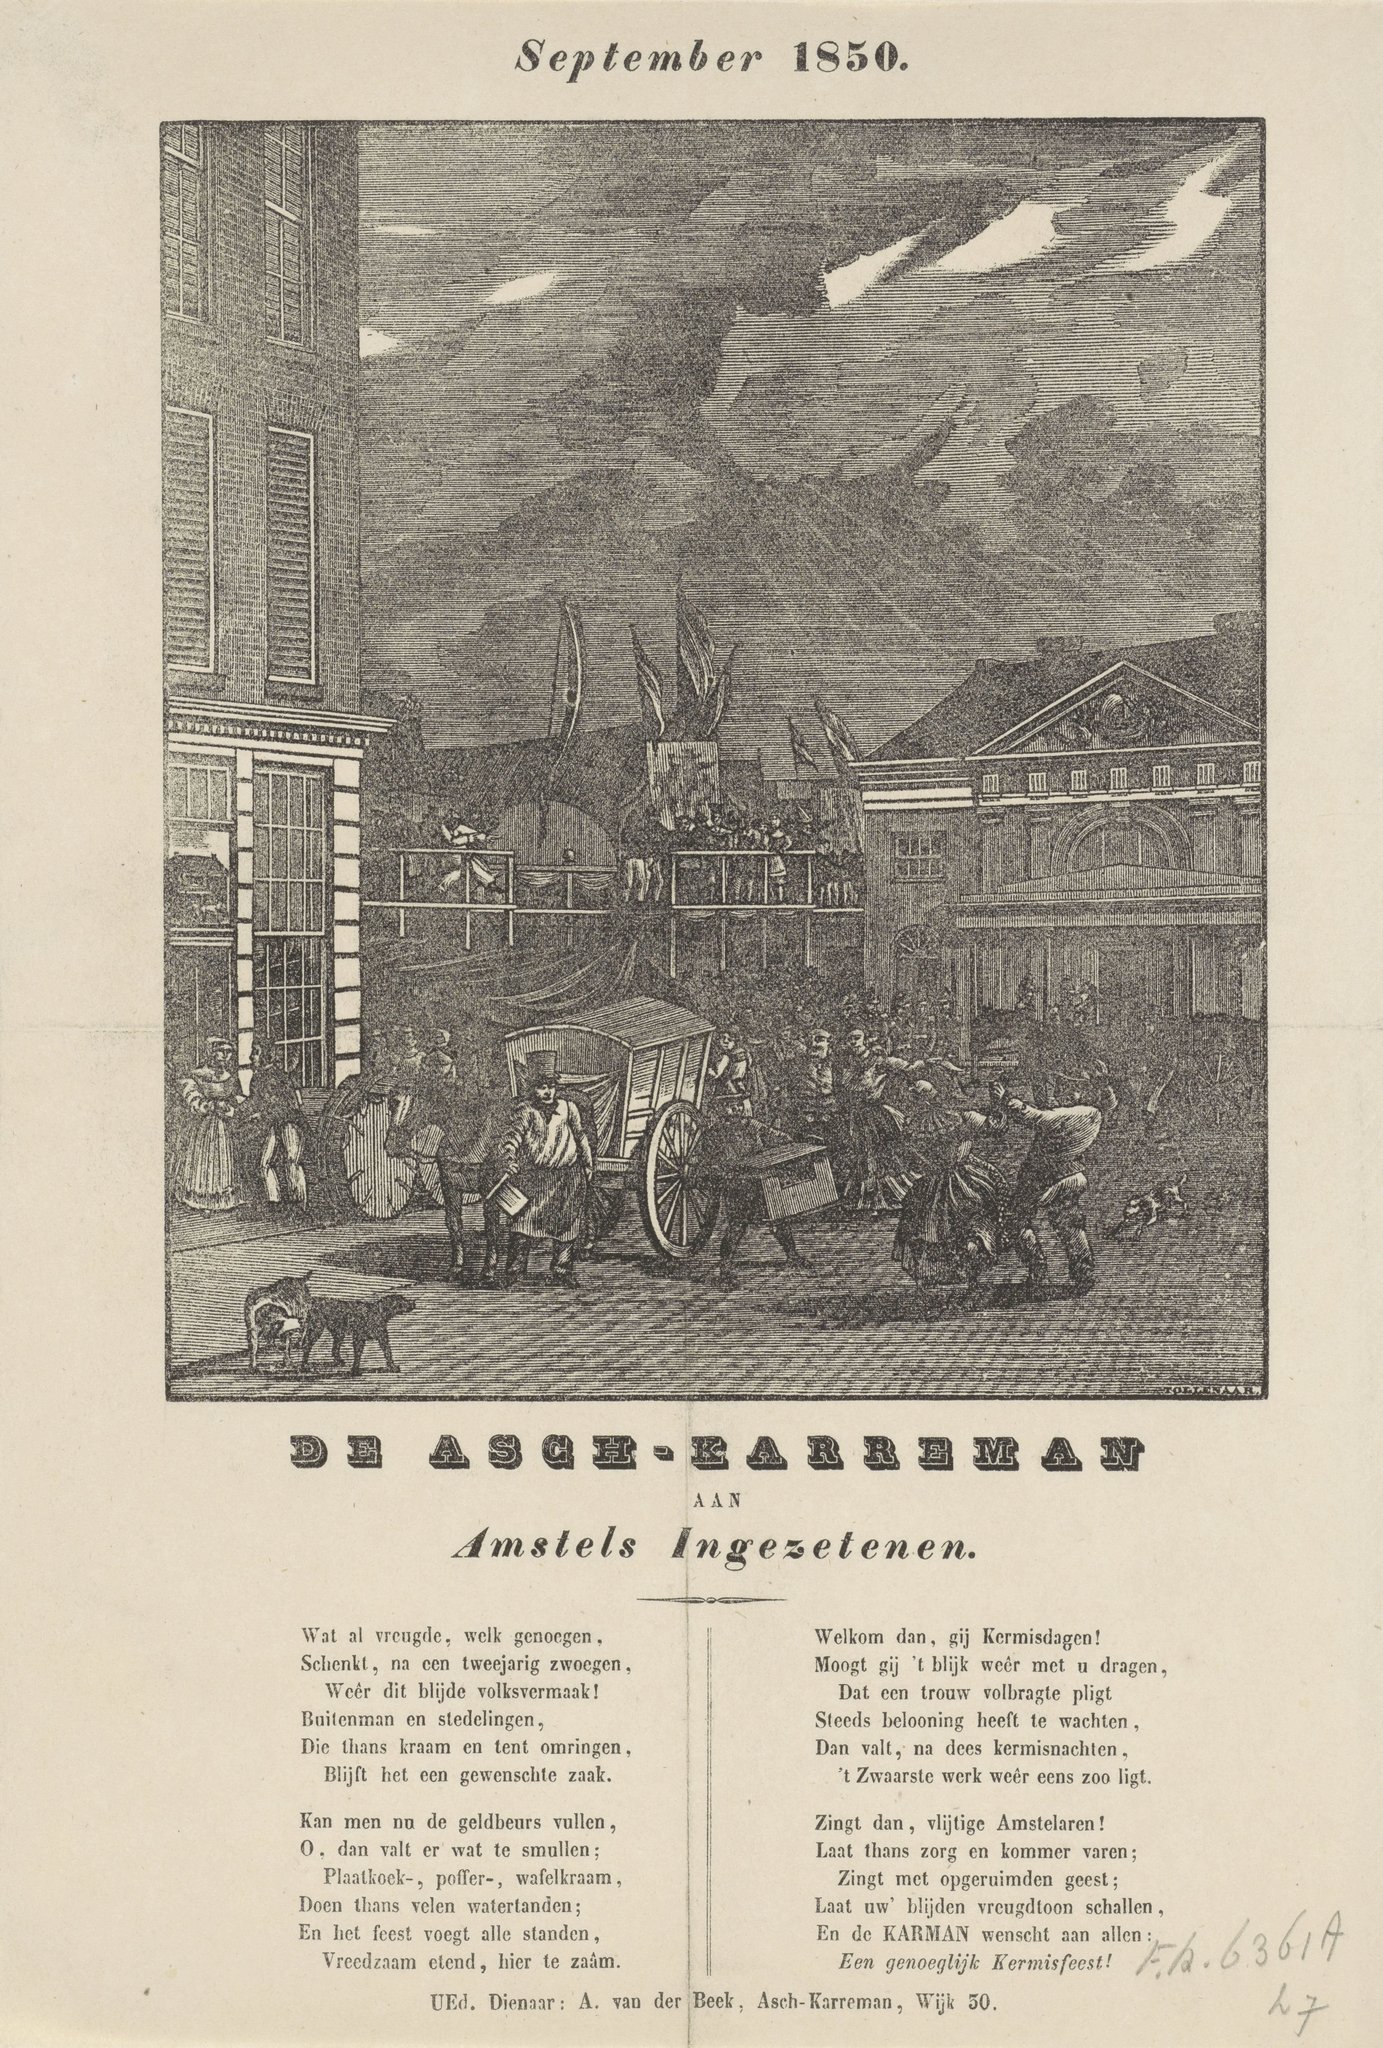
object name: fair print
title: September 1850 / De Asch-Karreman aan Amstels Ingezetenen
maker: dirk wijbrand tollenaar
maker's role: print maker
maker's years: 1808-1858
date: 1850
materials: paper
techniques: letterpress printing, engraving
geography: amsterdam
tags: public road - ii - ideal city, pleasure fair and circus, garbage collection, amsterdam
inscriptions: collector's mark: Lugt 2228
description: Kermisprent namens de askarrenmannen (karrenman of vuilnisman) te Amsterdam, september 1850. Gezicht op de kermis op de Botermarkt met de Regulierswaag. Op de markt twee vuilniskarren. Onderaan een gedicht in twee kolommen. Namens A. van der Beek, de askarreman van wijk no. 30.